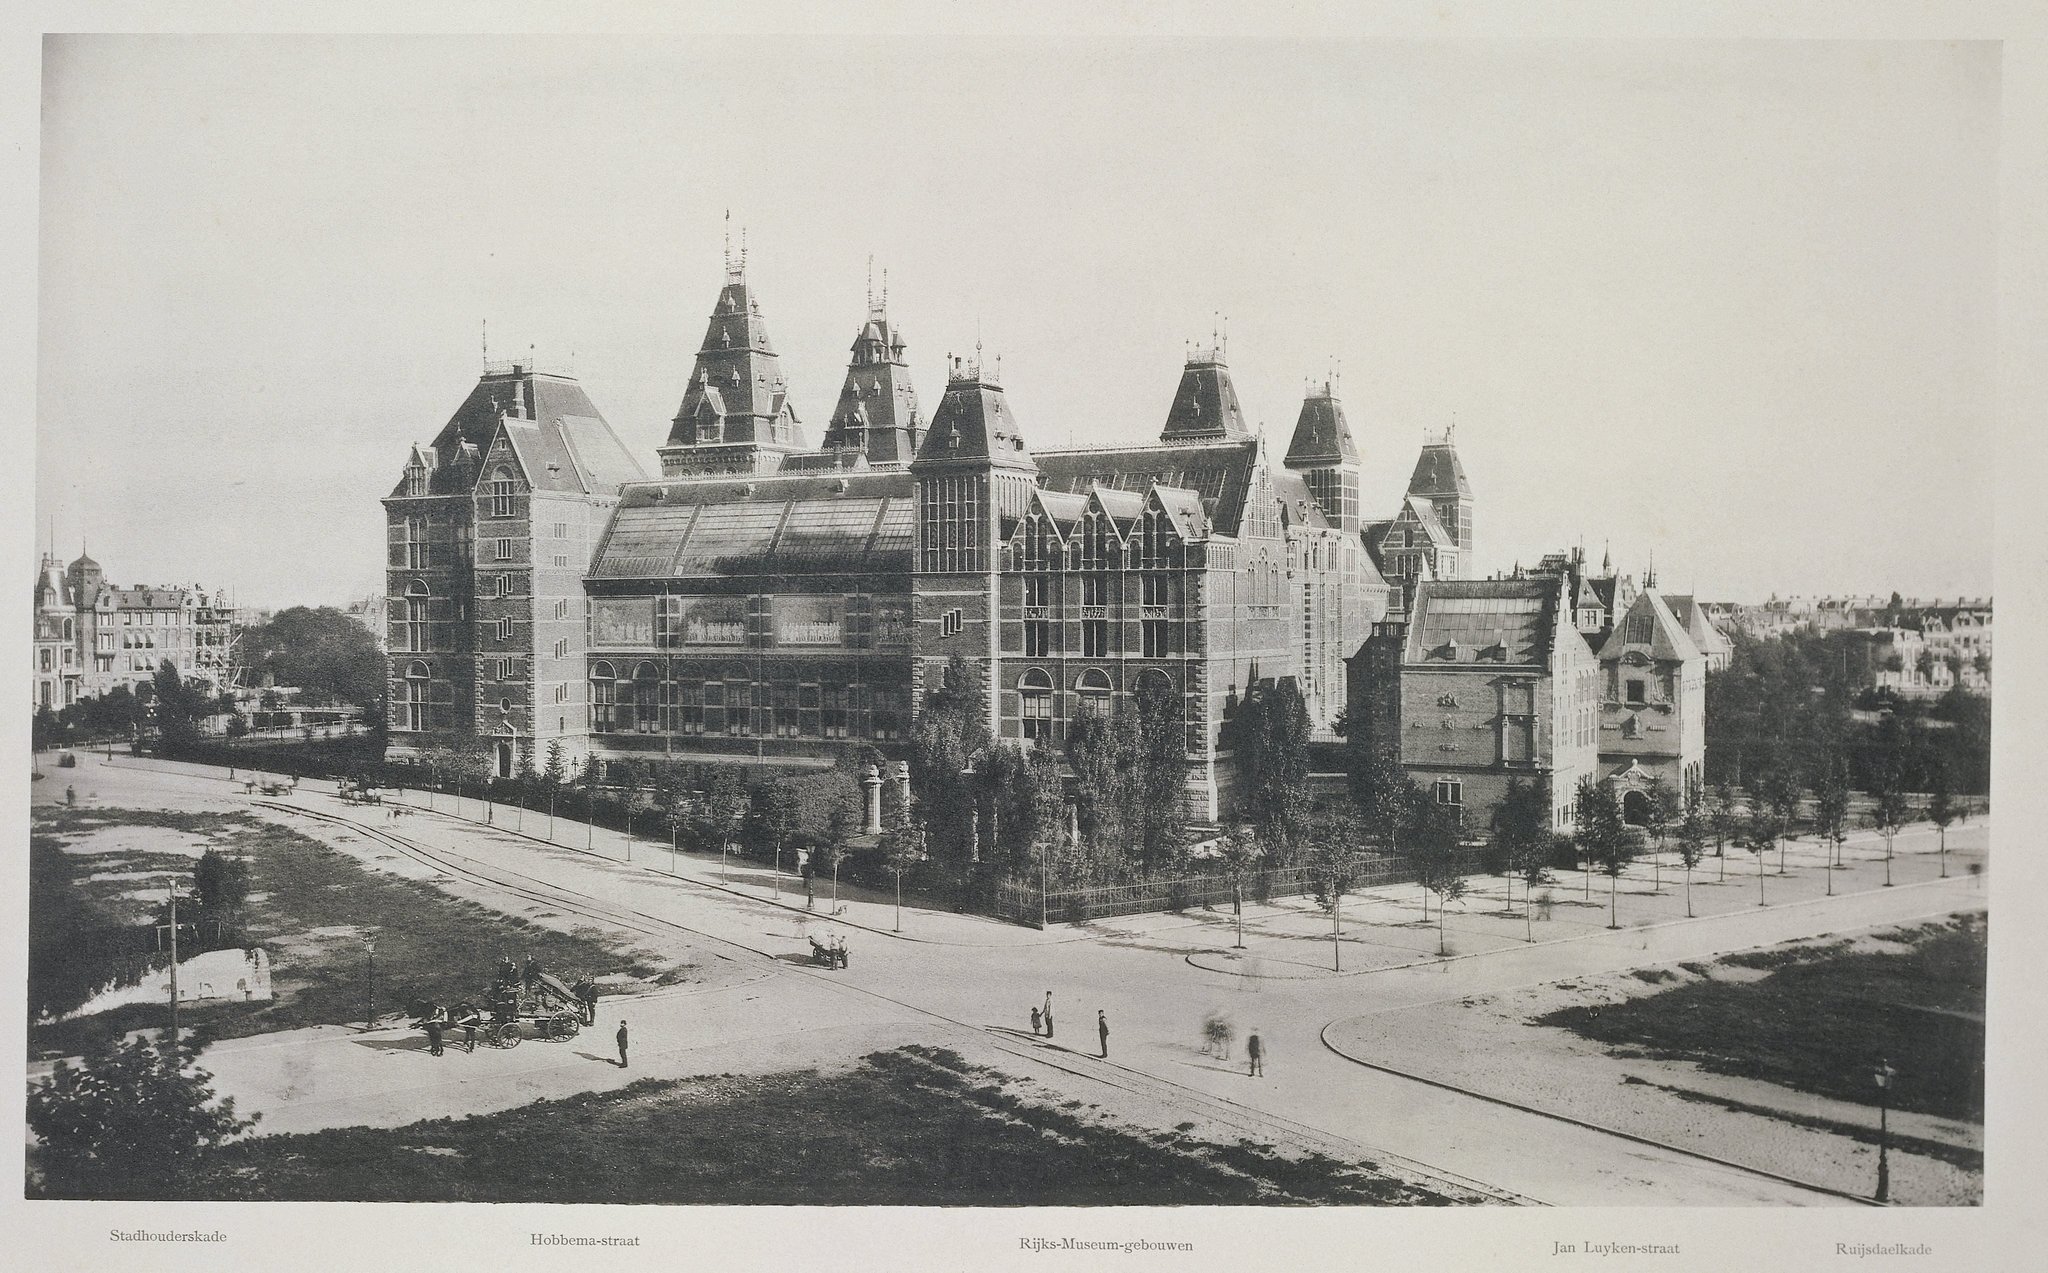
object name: photomechanical print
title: Rijksmuseum, gezien vanaf de achterzijde van een pand in de P.C. Hooftstraat, Amsterdam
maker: gerrit hendricus heinen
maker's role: painter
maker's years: 1851-1930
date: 1889-1894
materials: paper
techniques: photograph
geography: amsterdam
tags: permanent exhibition, museum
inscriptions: check stamp: ‘G.H. Heinen Amsterdam/ Schilder & Fotograaf’